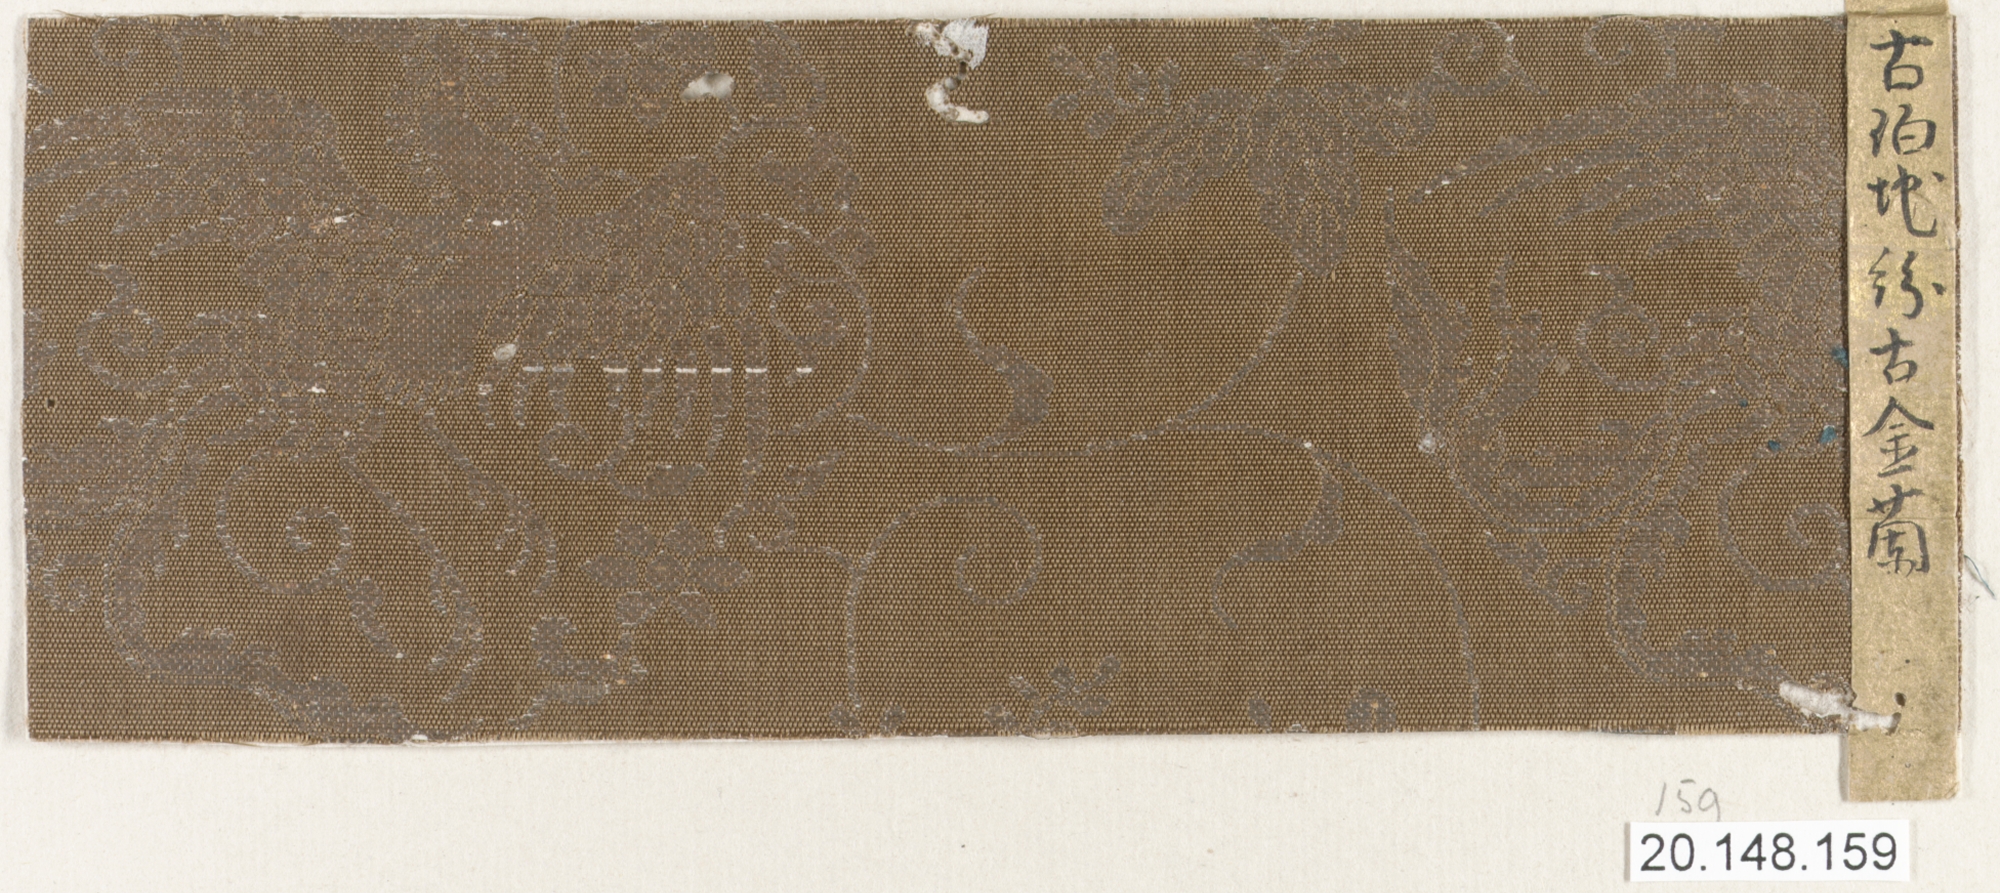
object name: piece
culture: japanese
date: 1701-1800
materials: silk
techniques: compound weave